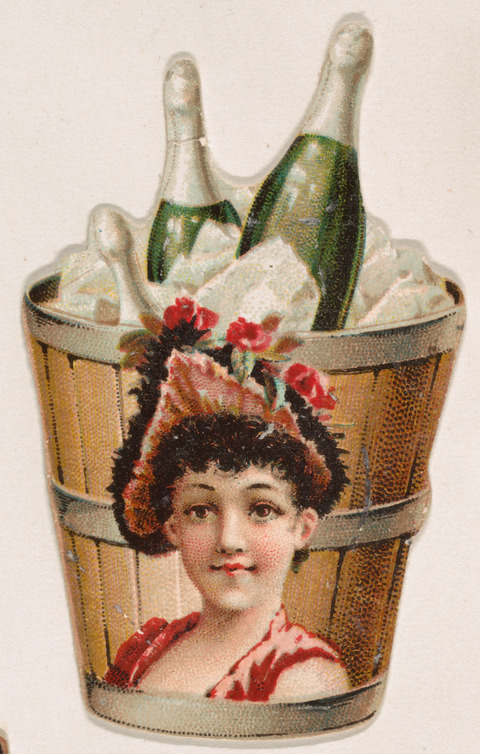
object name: print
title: Ice Bucket, from the Novelties series (N228, Type 3) issued by Kinney Bros.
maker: kinney brothers tobacco company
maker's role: publisher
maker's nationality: american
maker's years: 1869-2011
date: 1889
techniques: color lithograph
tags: women,bottles,buckets